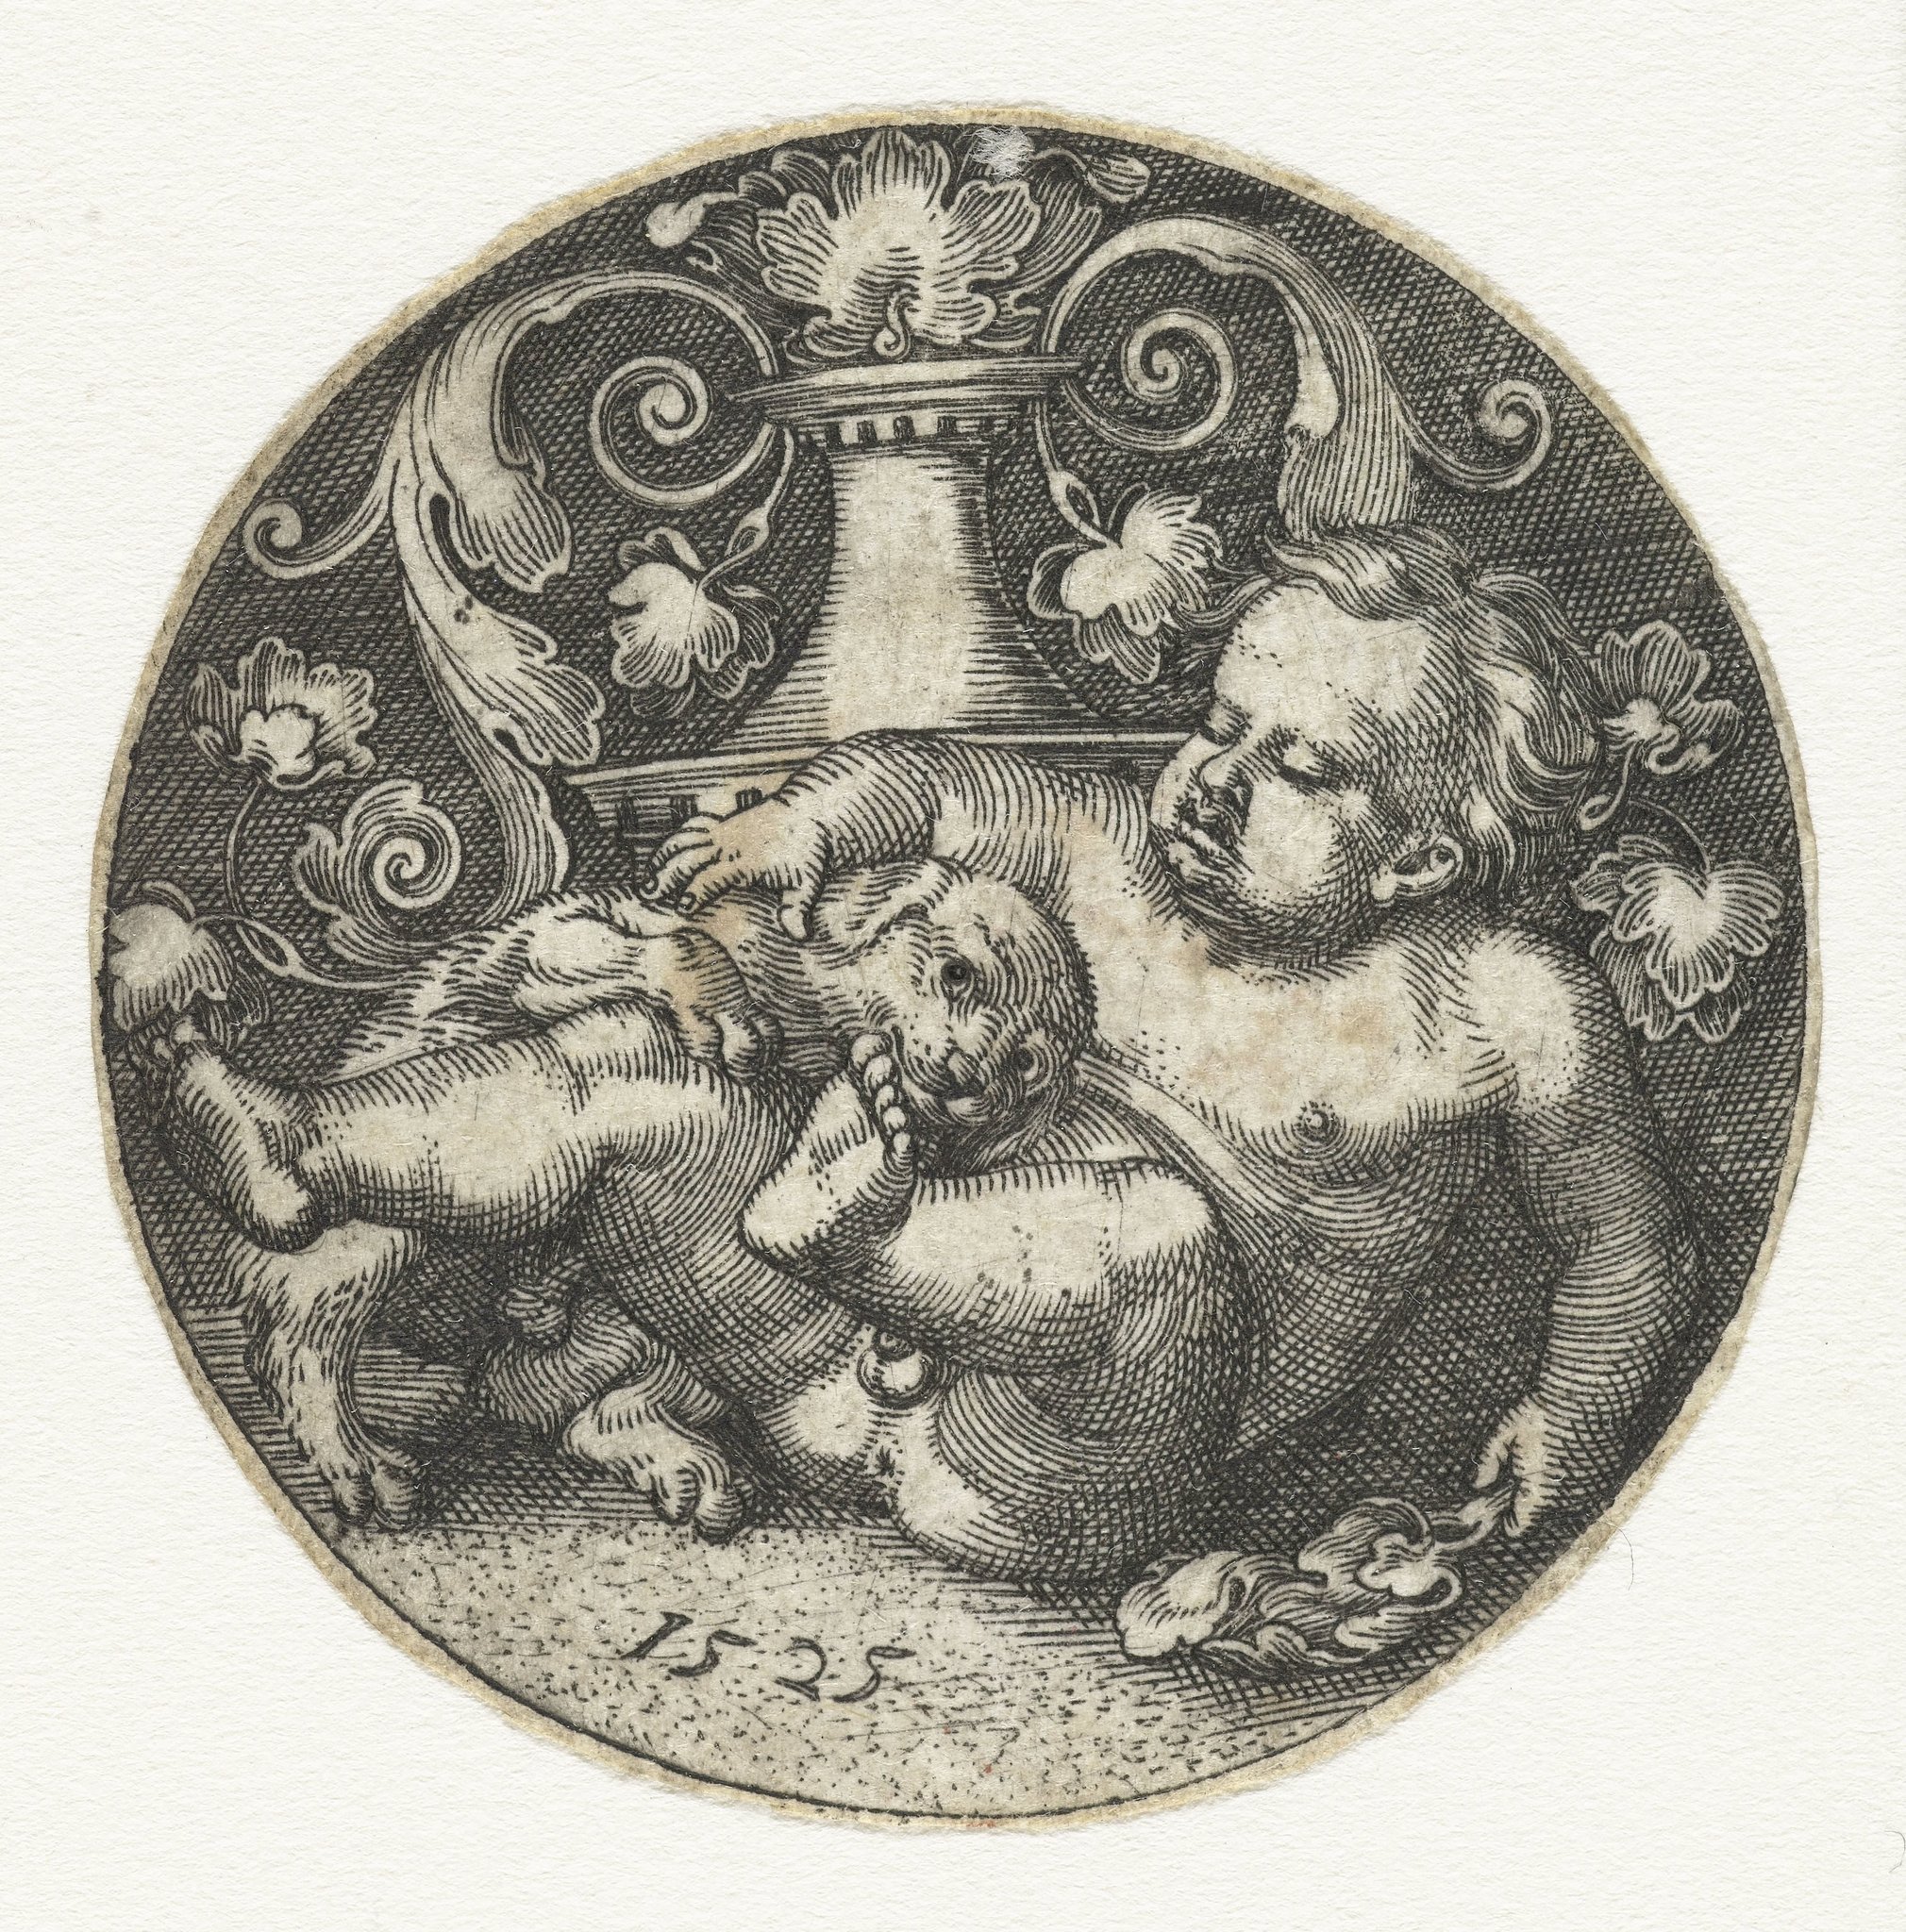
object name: print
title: Spelend kind met hond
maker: barthel beham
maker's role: print maker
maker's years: 1502-1540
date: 1525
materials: paper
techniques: engraving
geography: nuremberg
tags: child playing with animals, dog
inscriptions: collector's mark: Lugt 240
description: Ornamentprent met een kind dat speelt met een hond en bloemmotieven met bladwerk op de achtergrond op een cirkelvormige afdruk